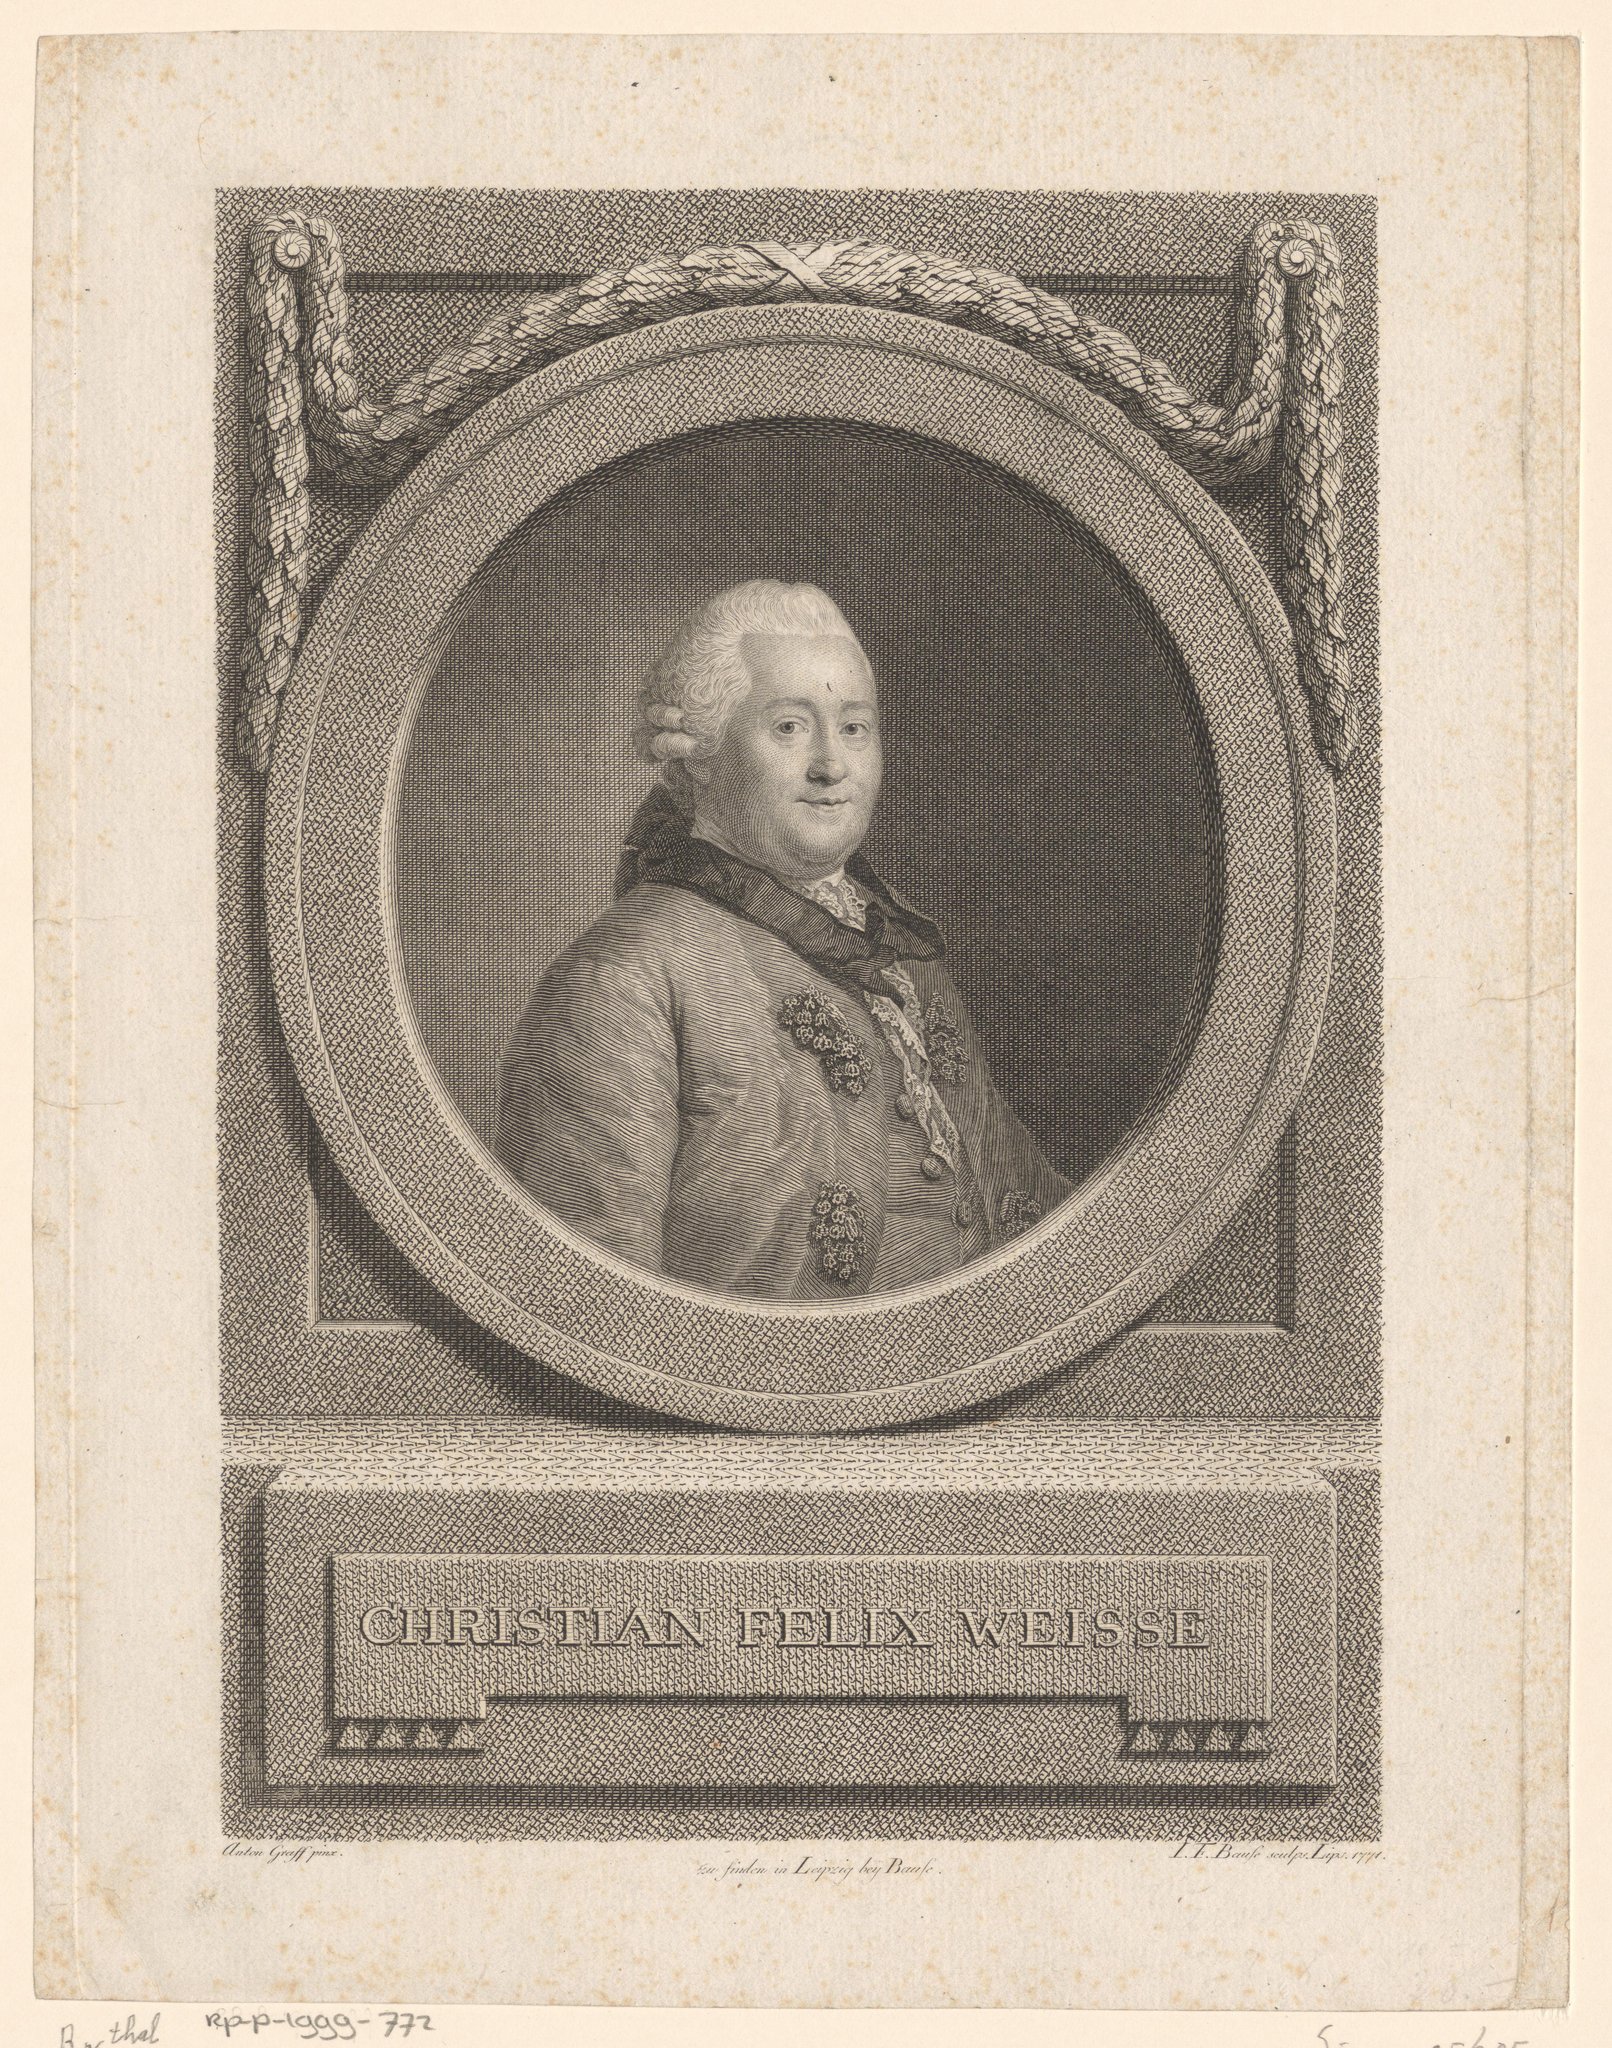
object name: print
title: Portret Christian Felix Weisse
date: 1771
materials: paper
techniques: engraving, etching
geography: leipzig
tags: historical persons, writer, poet, author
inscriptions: inscription: ‘Aukt. Helb. 1453/ 12 XII 04’, collector's mark: Lugt 2228, inscription: ‘Portr 56377/ Mappe schöne Portr.’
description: Portret van de dichter Christian Felix Weisse (1726-1804). Buste naar rechts, het hoofd naar links, in ronde omlijsting met guirlande. Het portret staat op een stenen sokkel waarop zijn naam.